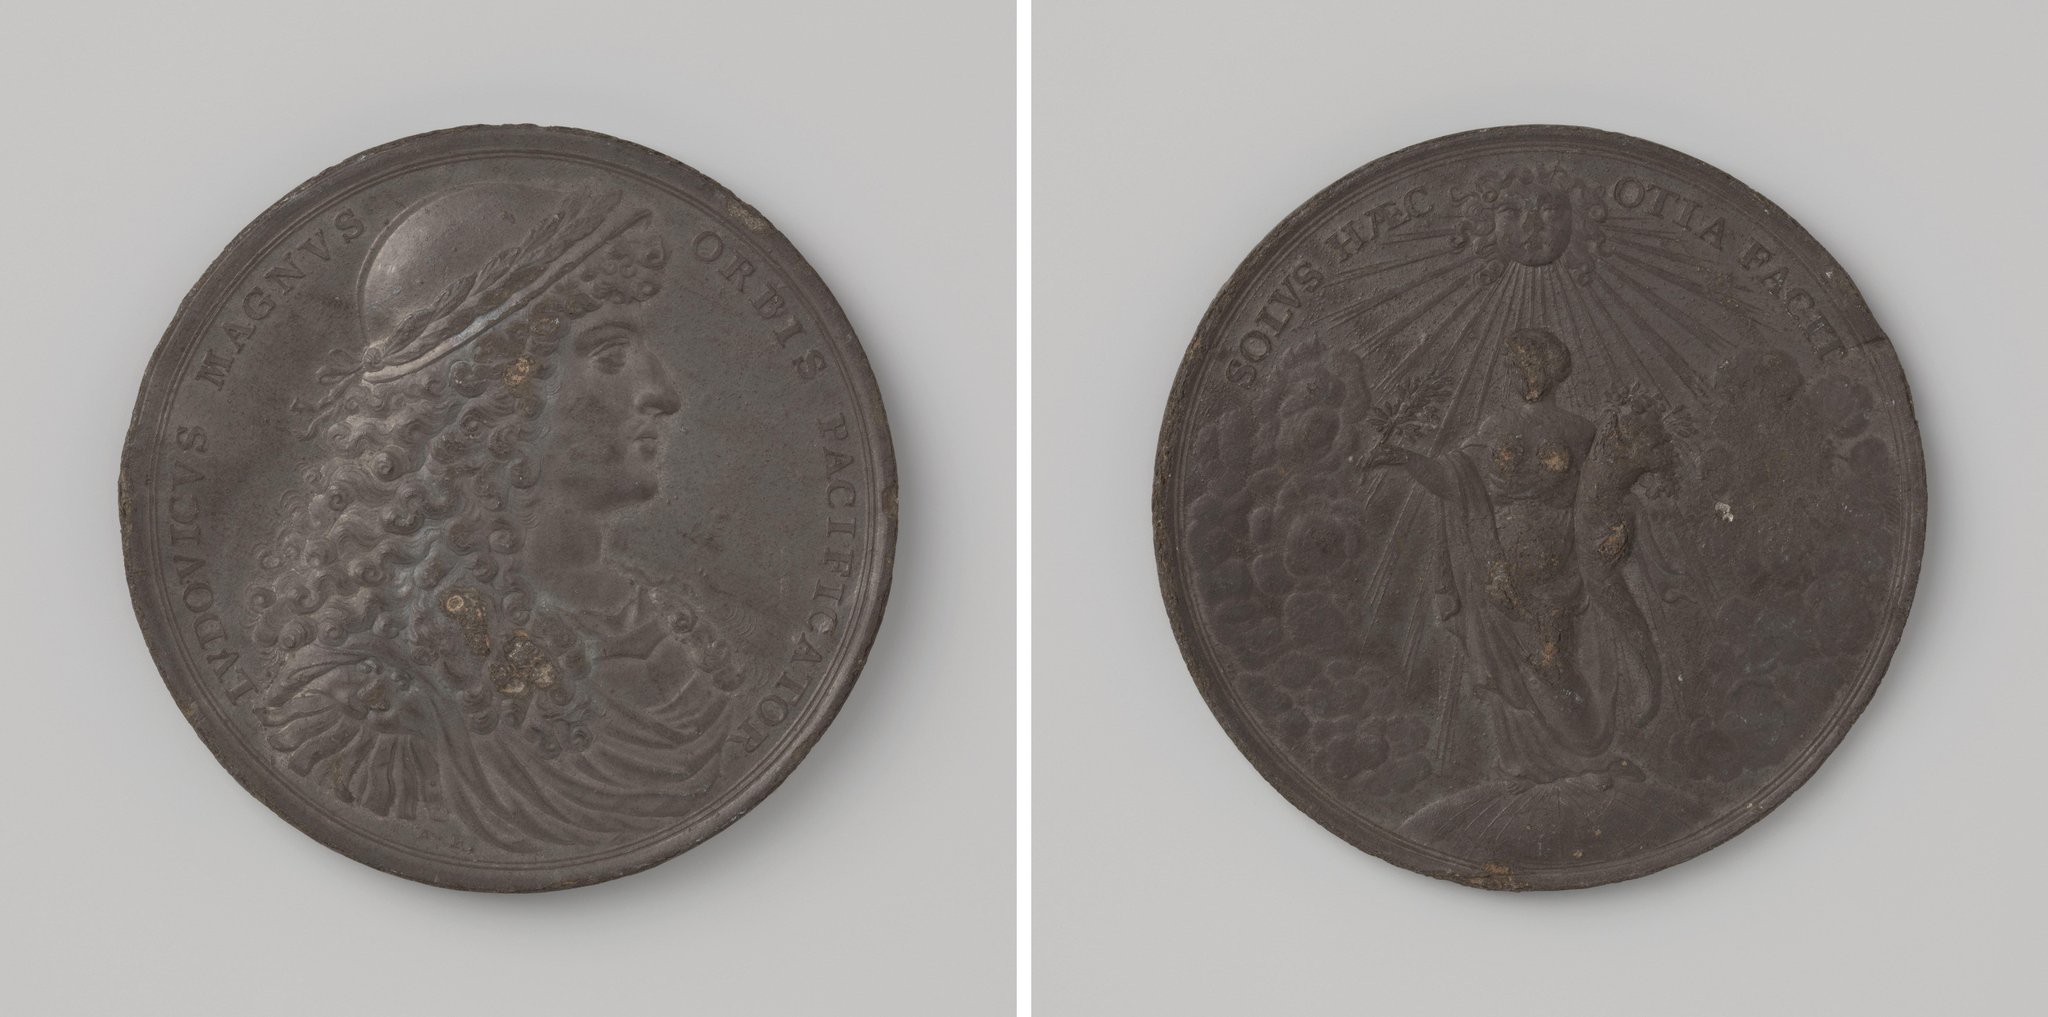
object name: history medal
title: Vrede van Rijswijk tussen Geallieerden en Frankrijk 1697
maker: reynier arondeaux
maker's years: 1678-1727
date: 1697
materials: tin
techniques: striking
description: Tinnen penning, op de voorzijde het borstbeeld van Koning Lodewijk XIV naar rechts met omschrift, op de keerzijde Pax met olijftak en hoorn des overvloeds staande op een wereldbol, tussen wolken en onder een stralende zon, met omschrift.